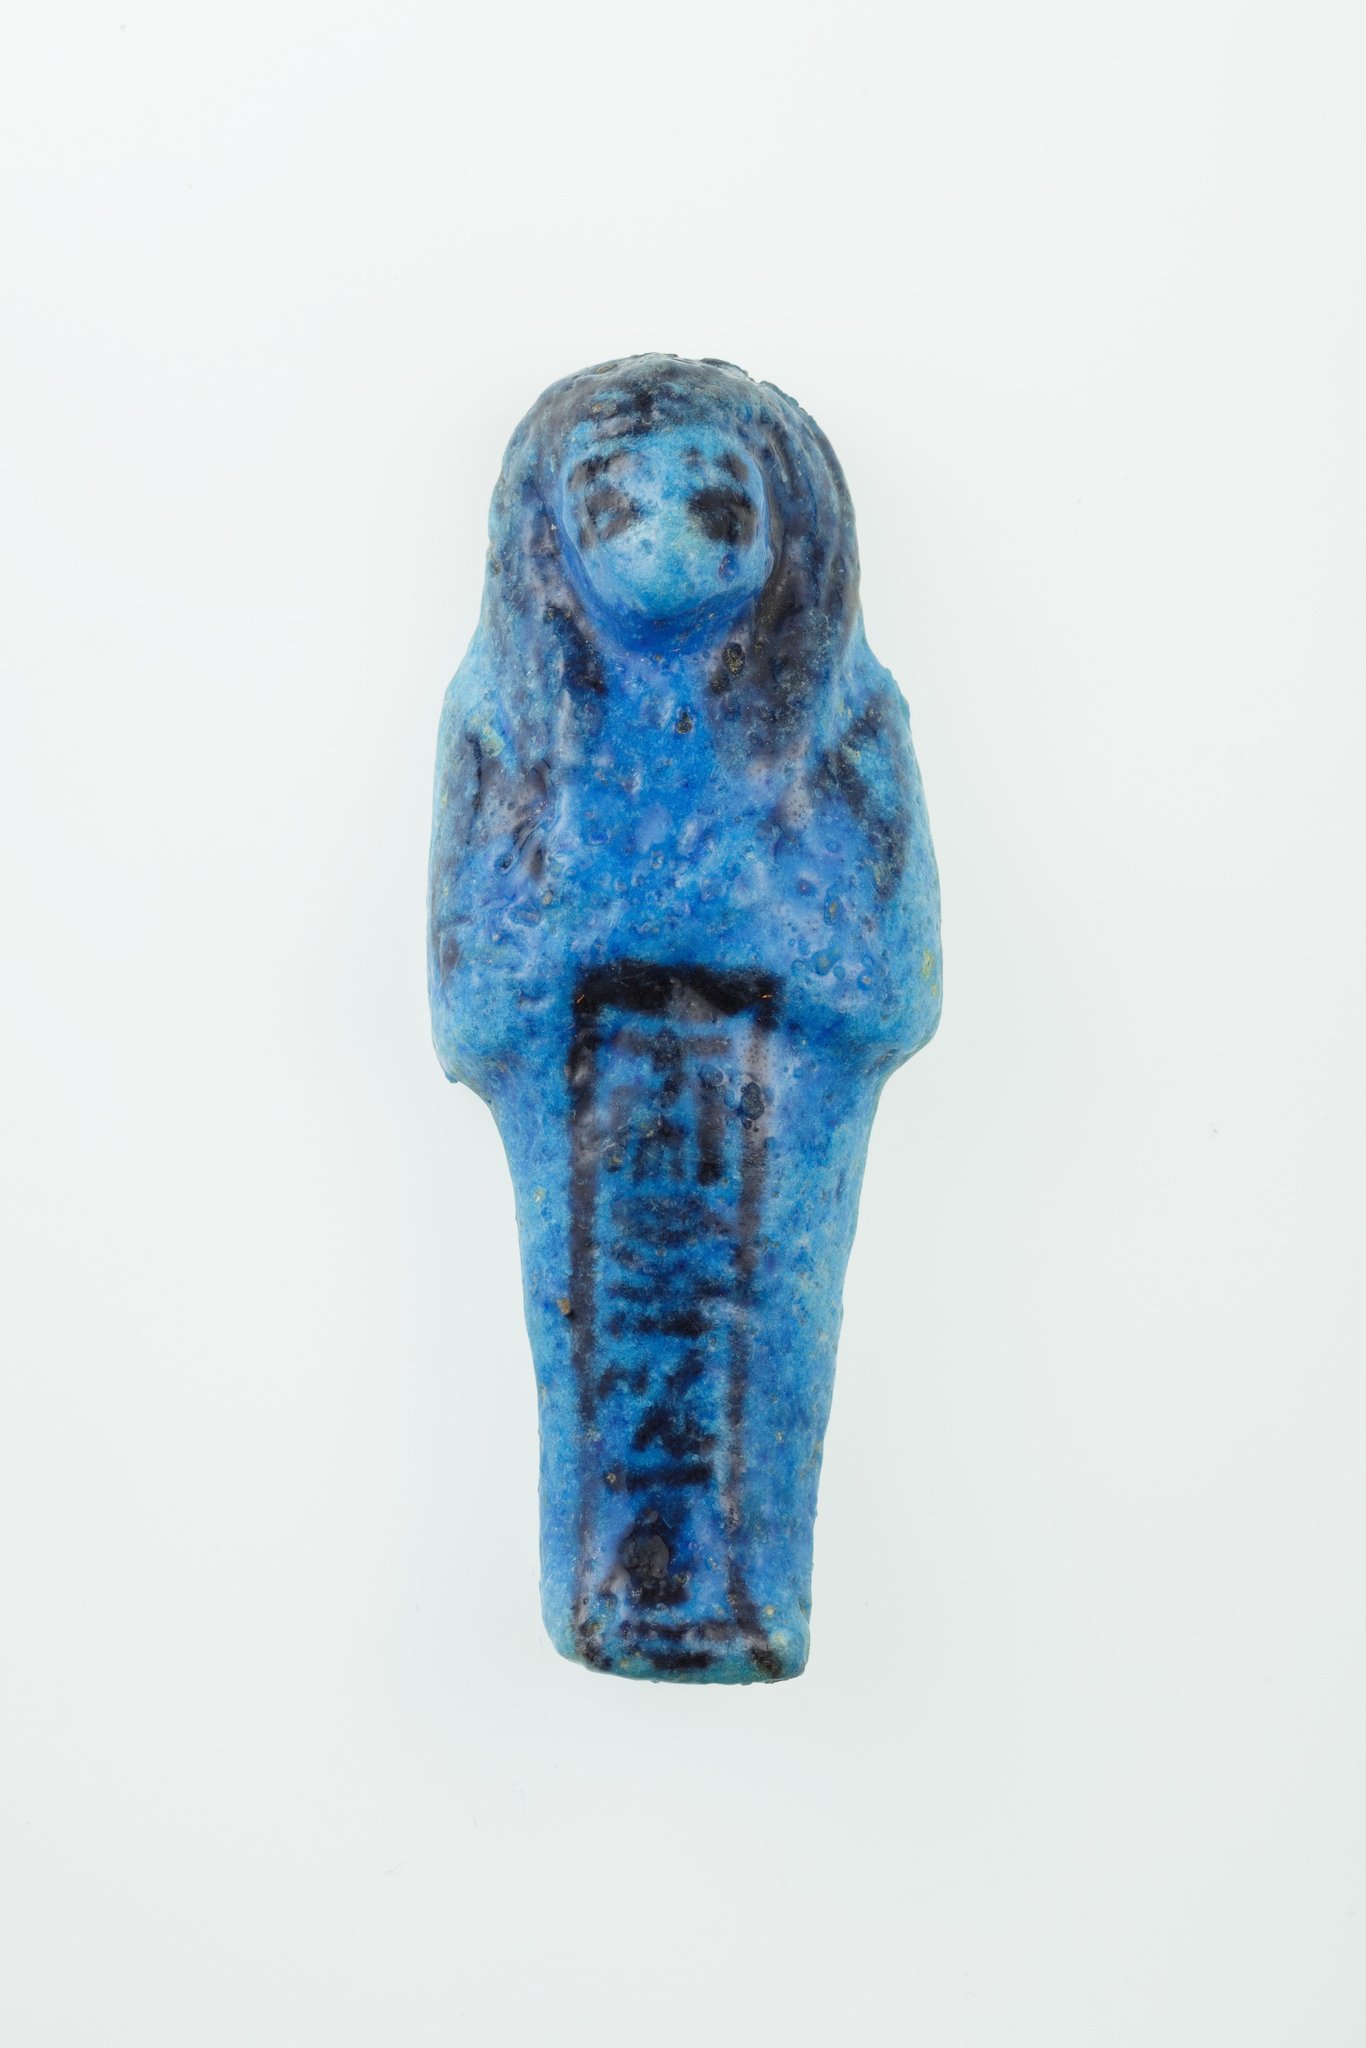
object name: shabti, worker, nauny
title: Worker Shabti of Nauny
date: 1050 BCE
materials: faience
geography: egypt